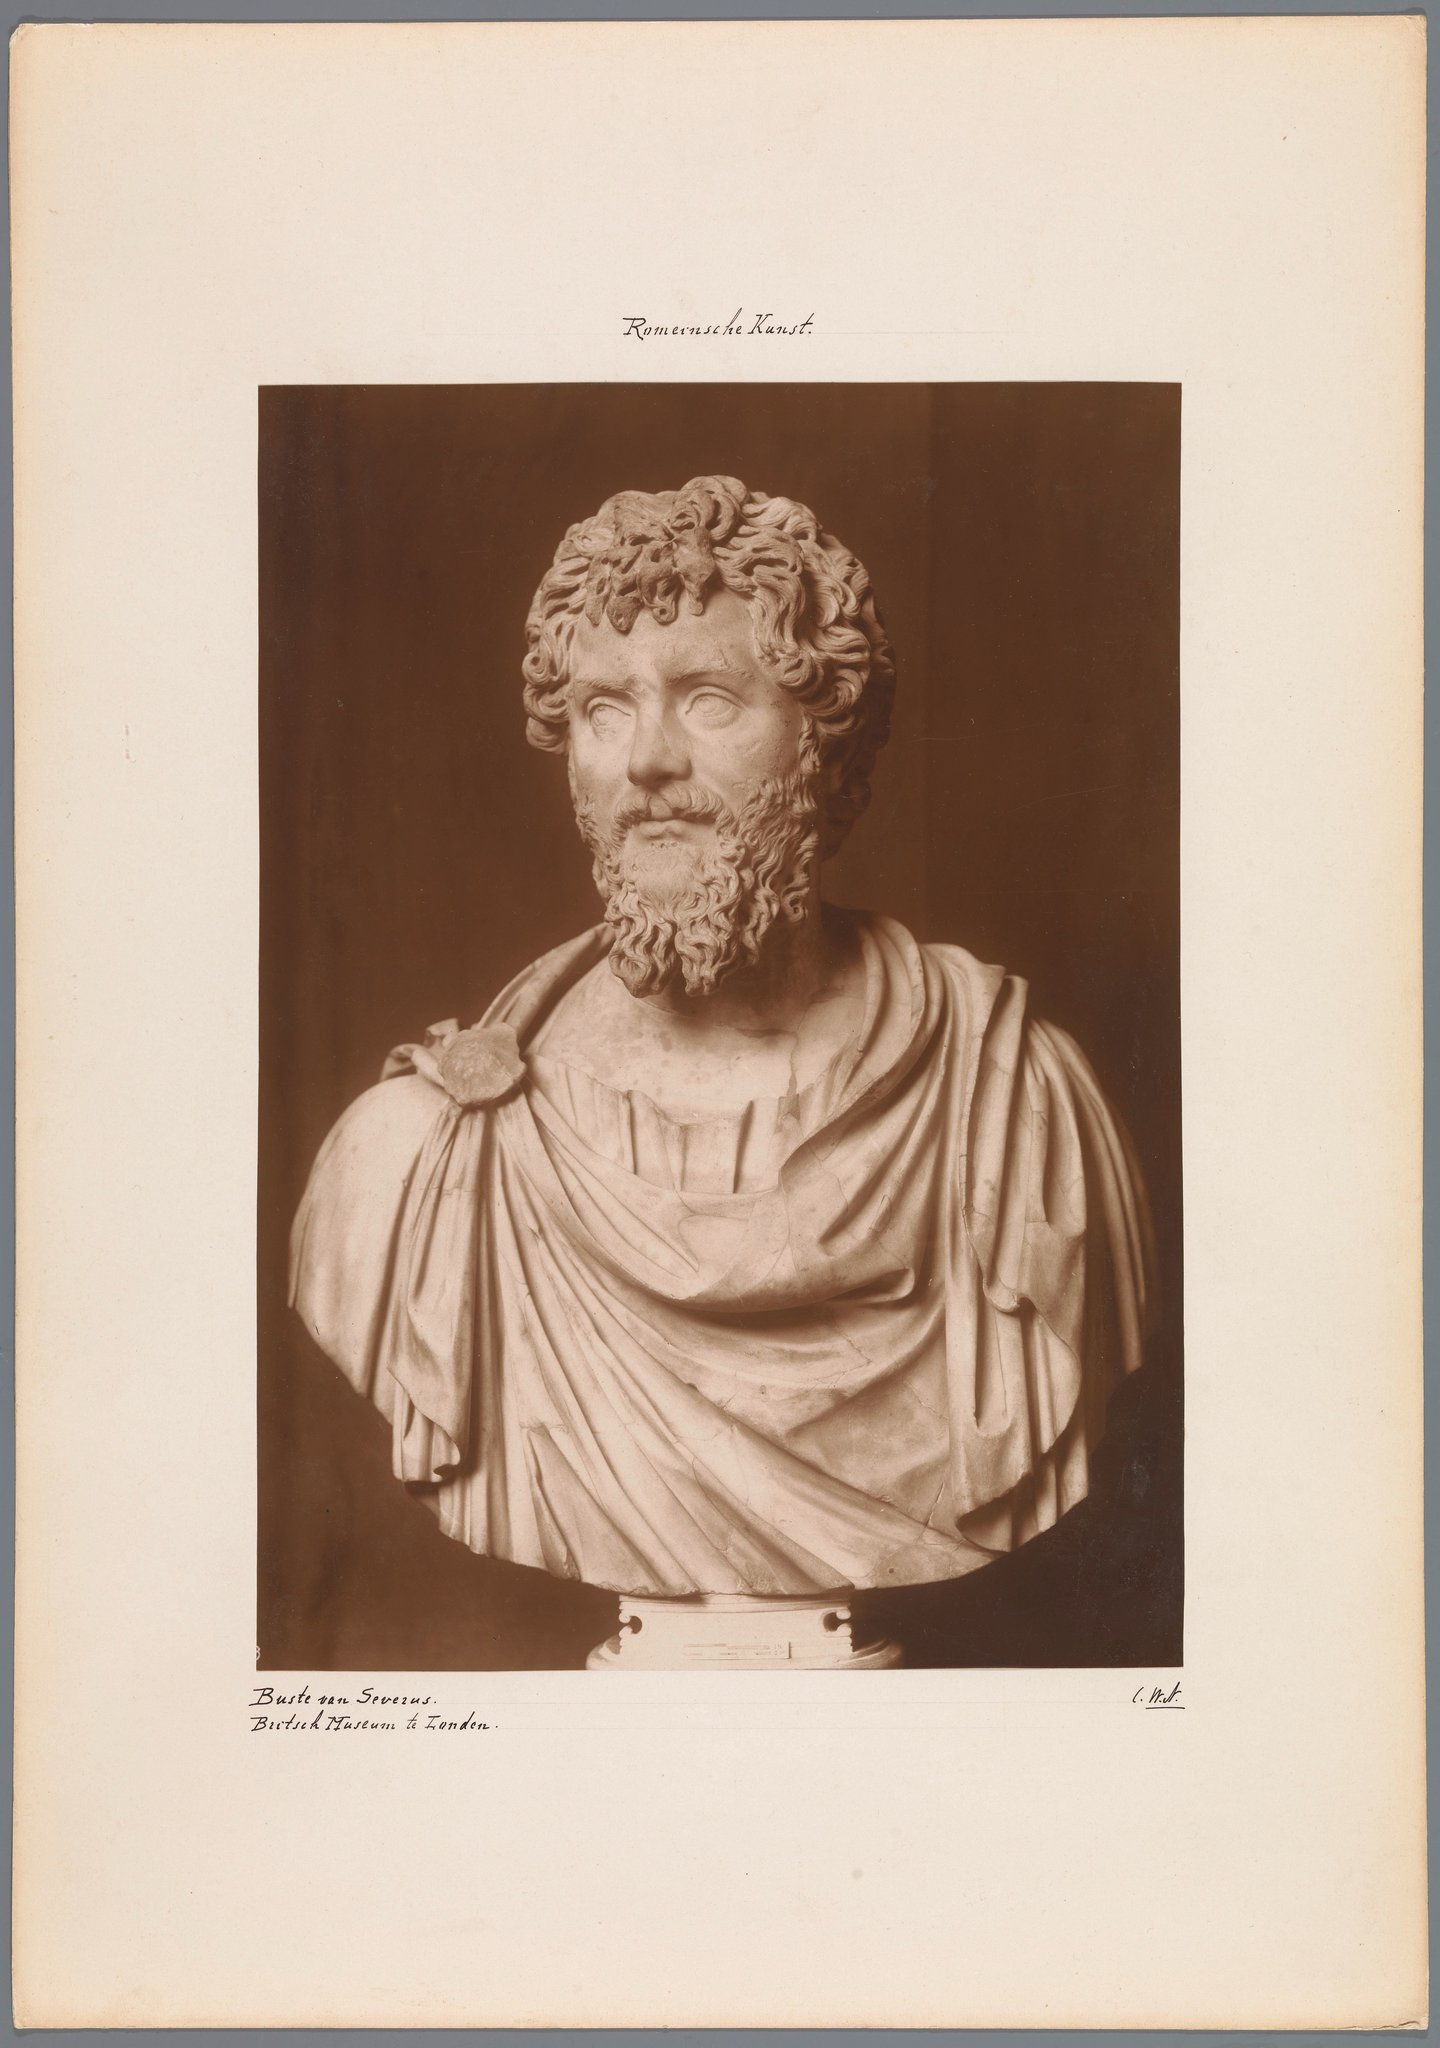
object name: photograph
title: Buste van Septimus Severus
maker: Anonymous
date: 1875-1900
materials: cardboard, photographic support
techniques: carbon print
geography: london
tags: male persons from classical history (+ head, bust, etc.), (story of) the emperor septimius severus, piece of sculpture, reproduction of a piece of sculpture, europe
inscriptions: inscription: ‘CWN.’, inscription: ‘Romeische Kunst.’, collector's mark: ‘KUNSTNIJVERHEIDSCHOOL QUELLINUS AMSTERDAM FRANS HALSSTRAAT 14.’, collector's mark: ‘INSTITUUT VOOR KUNST-NIJVERHEIDSONDERWIJS GABRIËL METSUSTRAAT No. 16 AMSTERDAM’, name: ‘W.A. MANSELL & CO COPYRIGHT [....] OXFORDST’